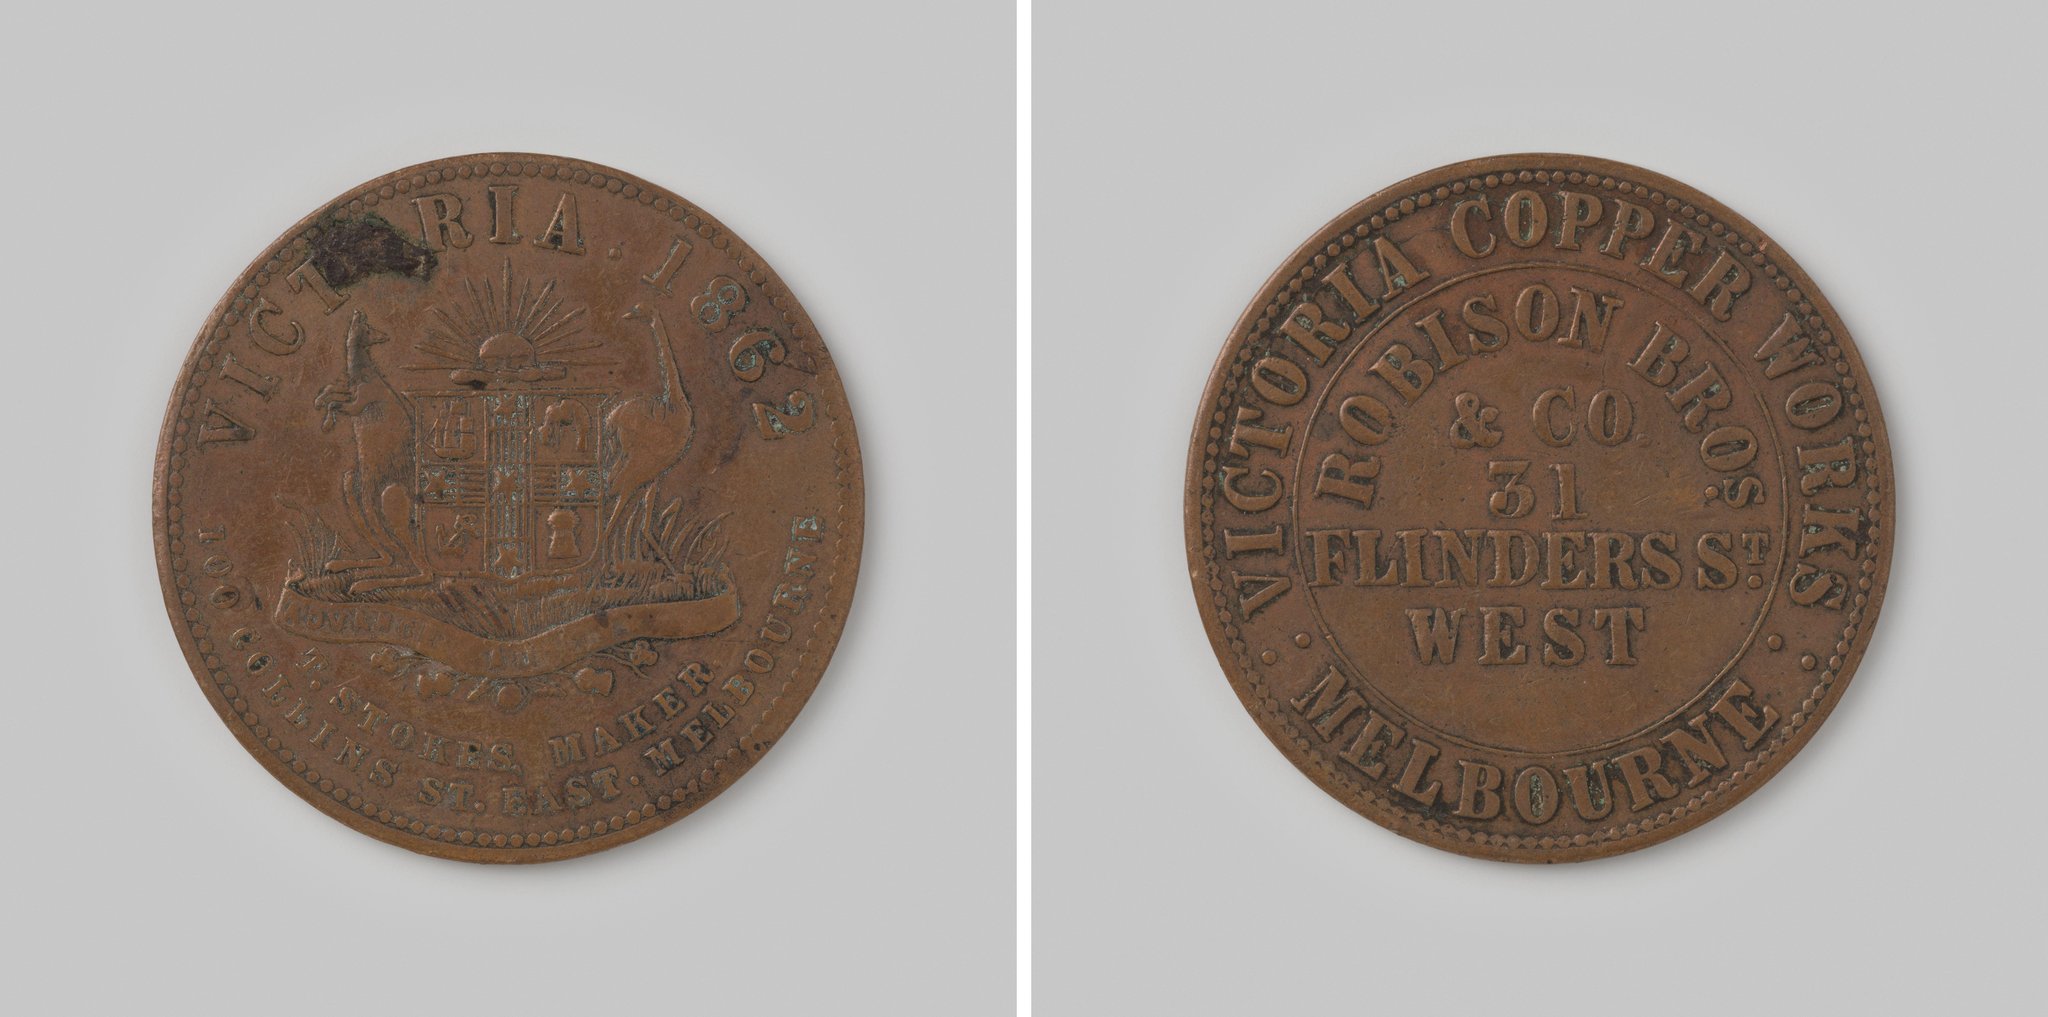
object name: coin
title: Penny van de firma Robinson Bros. & Co te Melbourne, Victoria, Australië, 1862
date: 1862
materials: copper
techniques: striking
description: Koperen particuliere munt. Voorzijde: door twee inheemse dieren gehouden wapenschild, waarboven stralende zon met mensengezicht en waaronder banderol met spreuk. Plaats-aanduiding en jaartal bovenaan in omschrift. Keerzijde: in vijf regels firma-aanduiding en adres-aanduiding. Gladde rand.